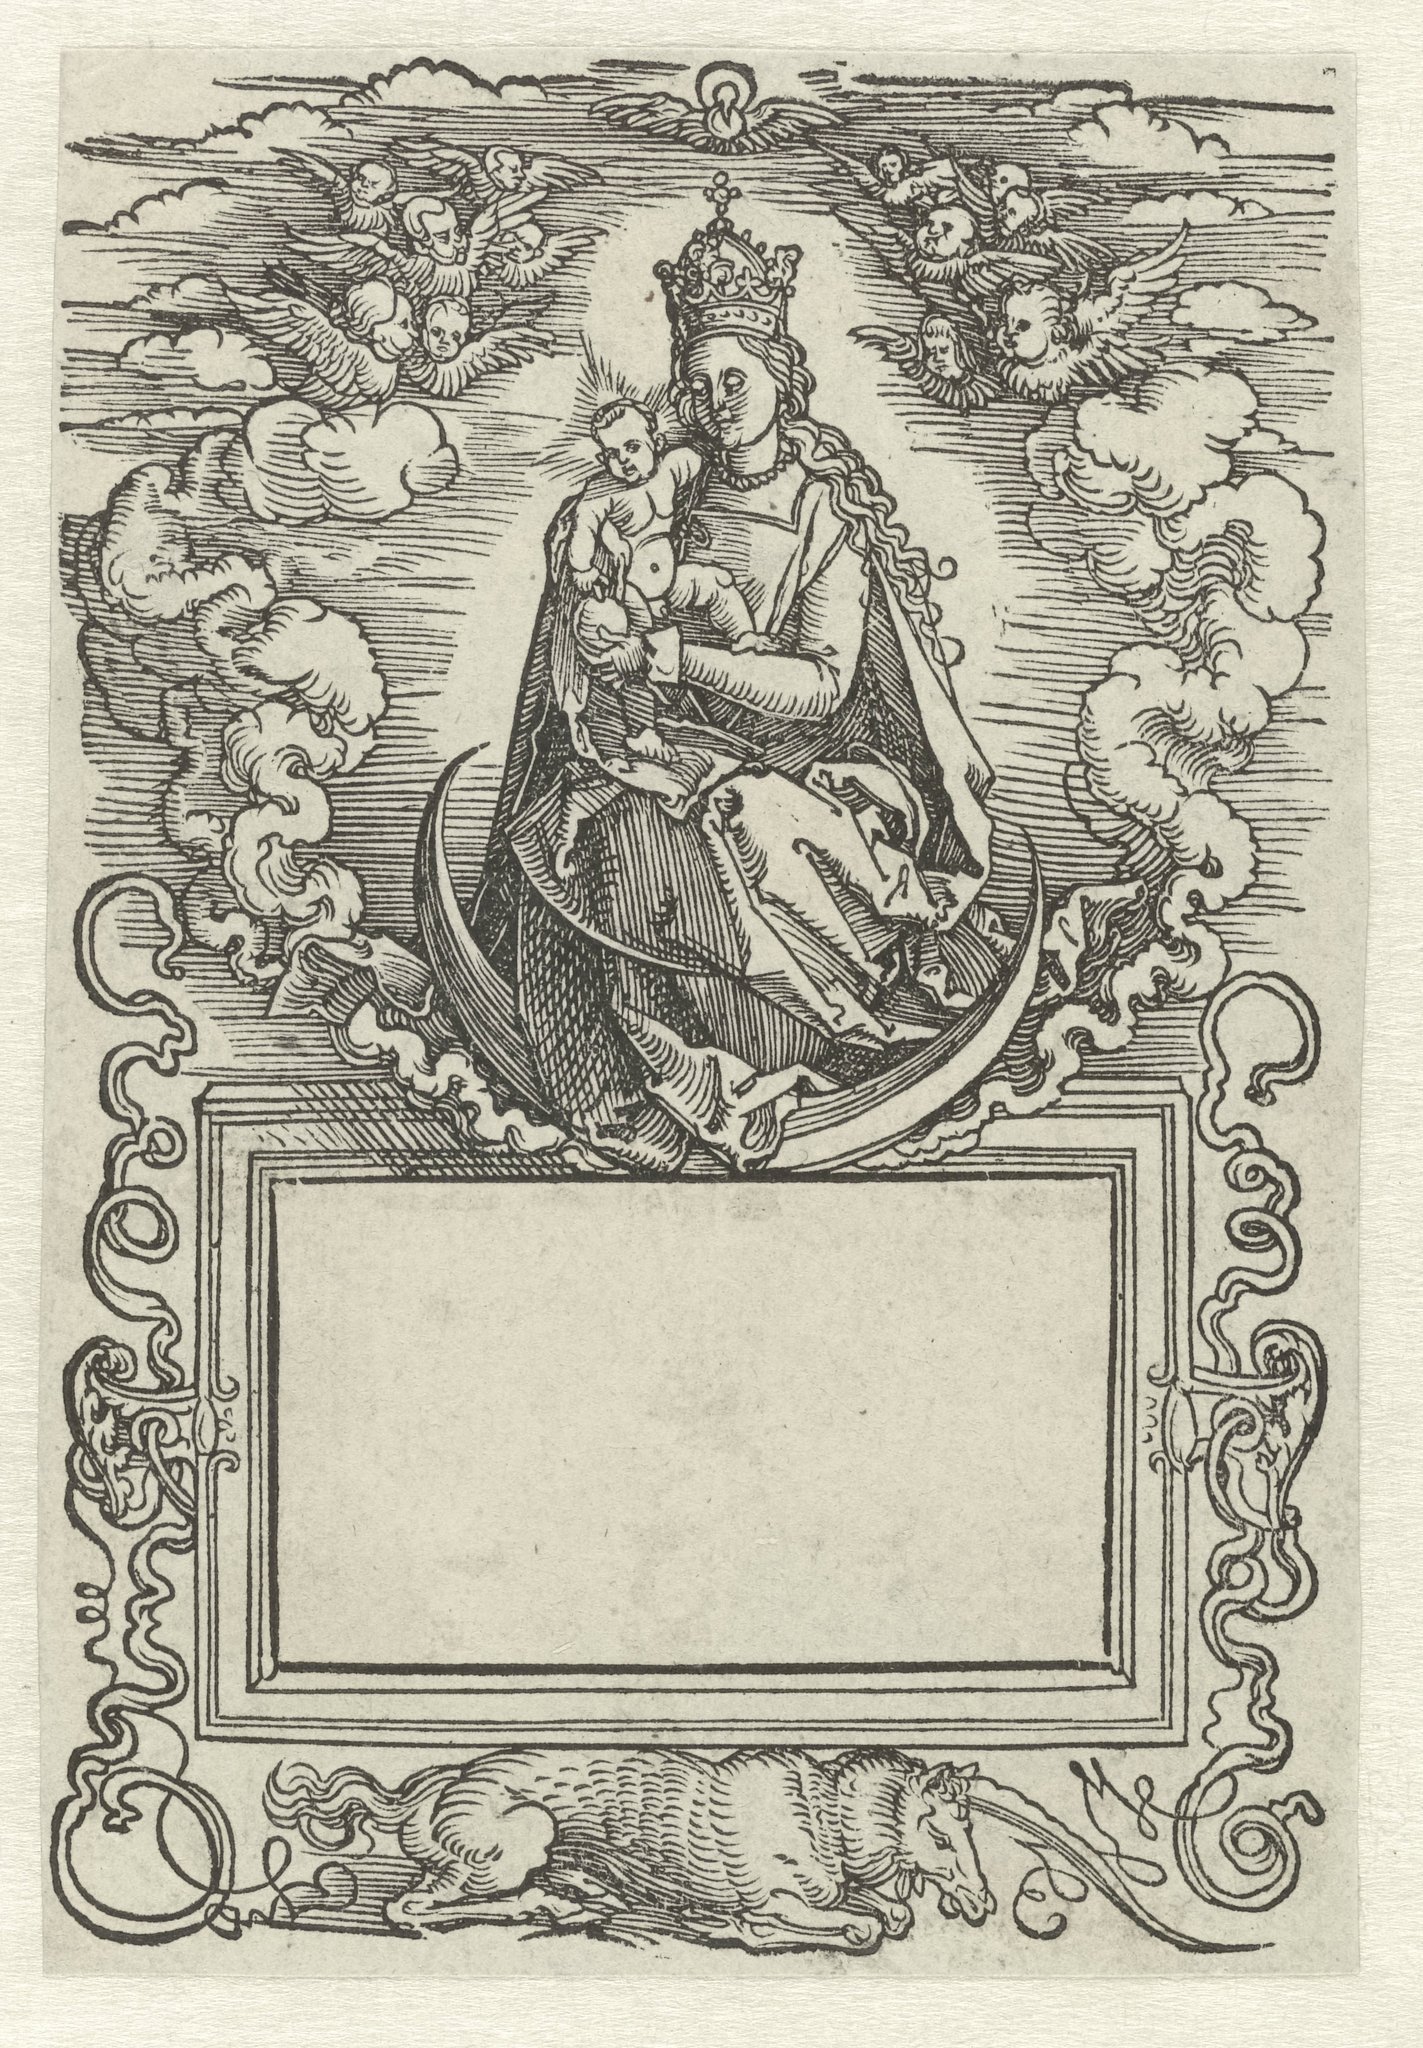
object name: print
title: Titelblad met Maria met kind zittend op de maansikkel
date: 1500-1516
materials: paper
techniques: woodcut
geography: nuremberg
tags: madonna: mary sitting or enthroned, the christ-child in her lap (or in front of her bosom) (mary sometimes represented half-length)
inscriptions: collector's mark: Lugt 240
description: Maria met het Christuskind op de arm, gezeten op een maansikkel, omgeven door wolken en engeltjes. Daaronder een tablet, bedoeld voor een tekst, maar hier leeg gelaten.